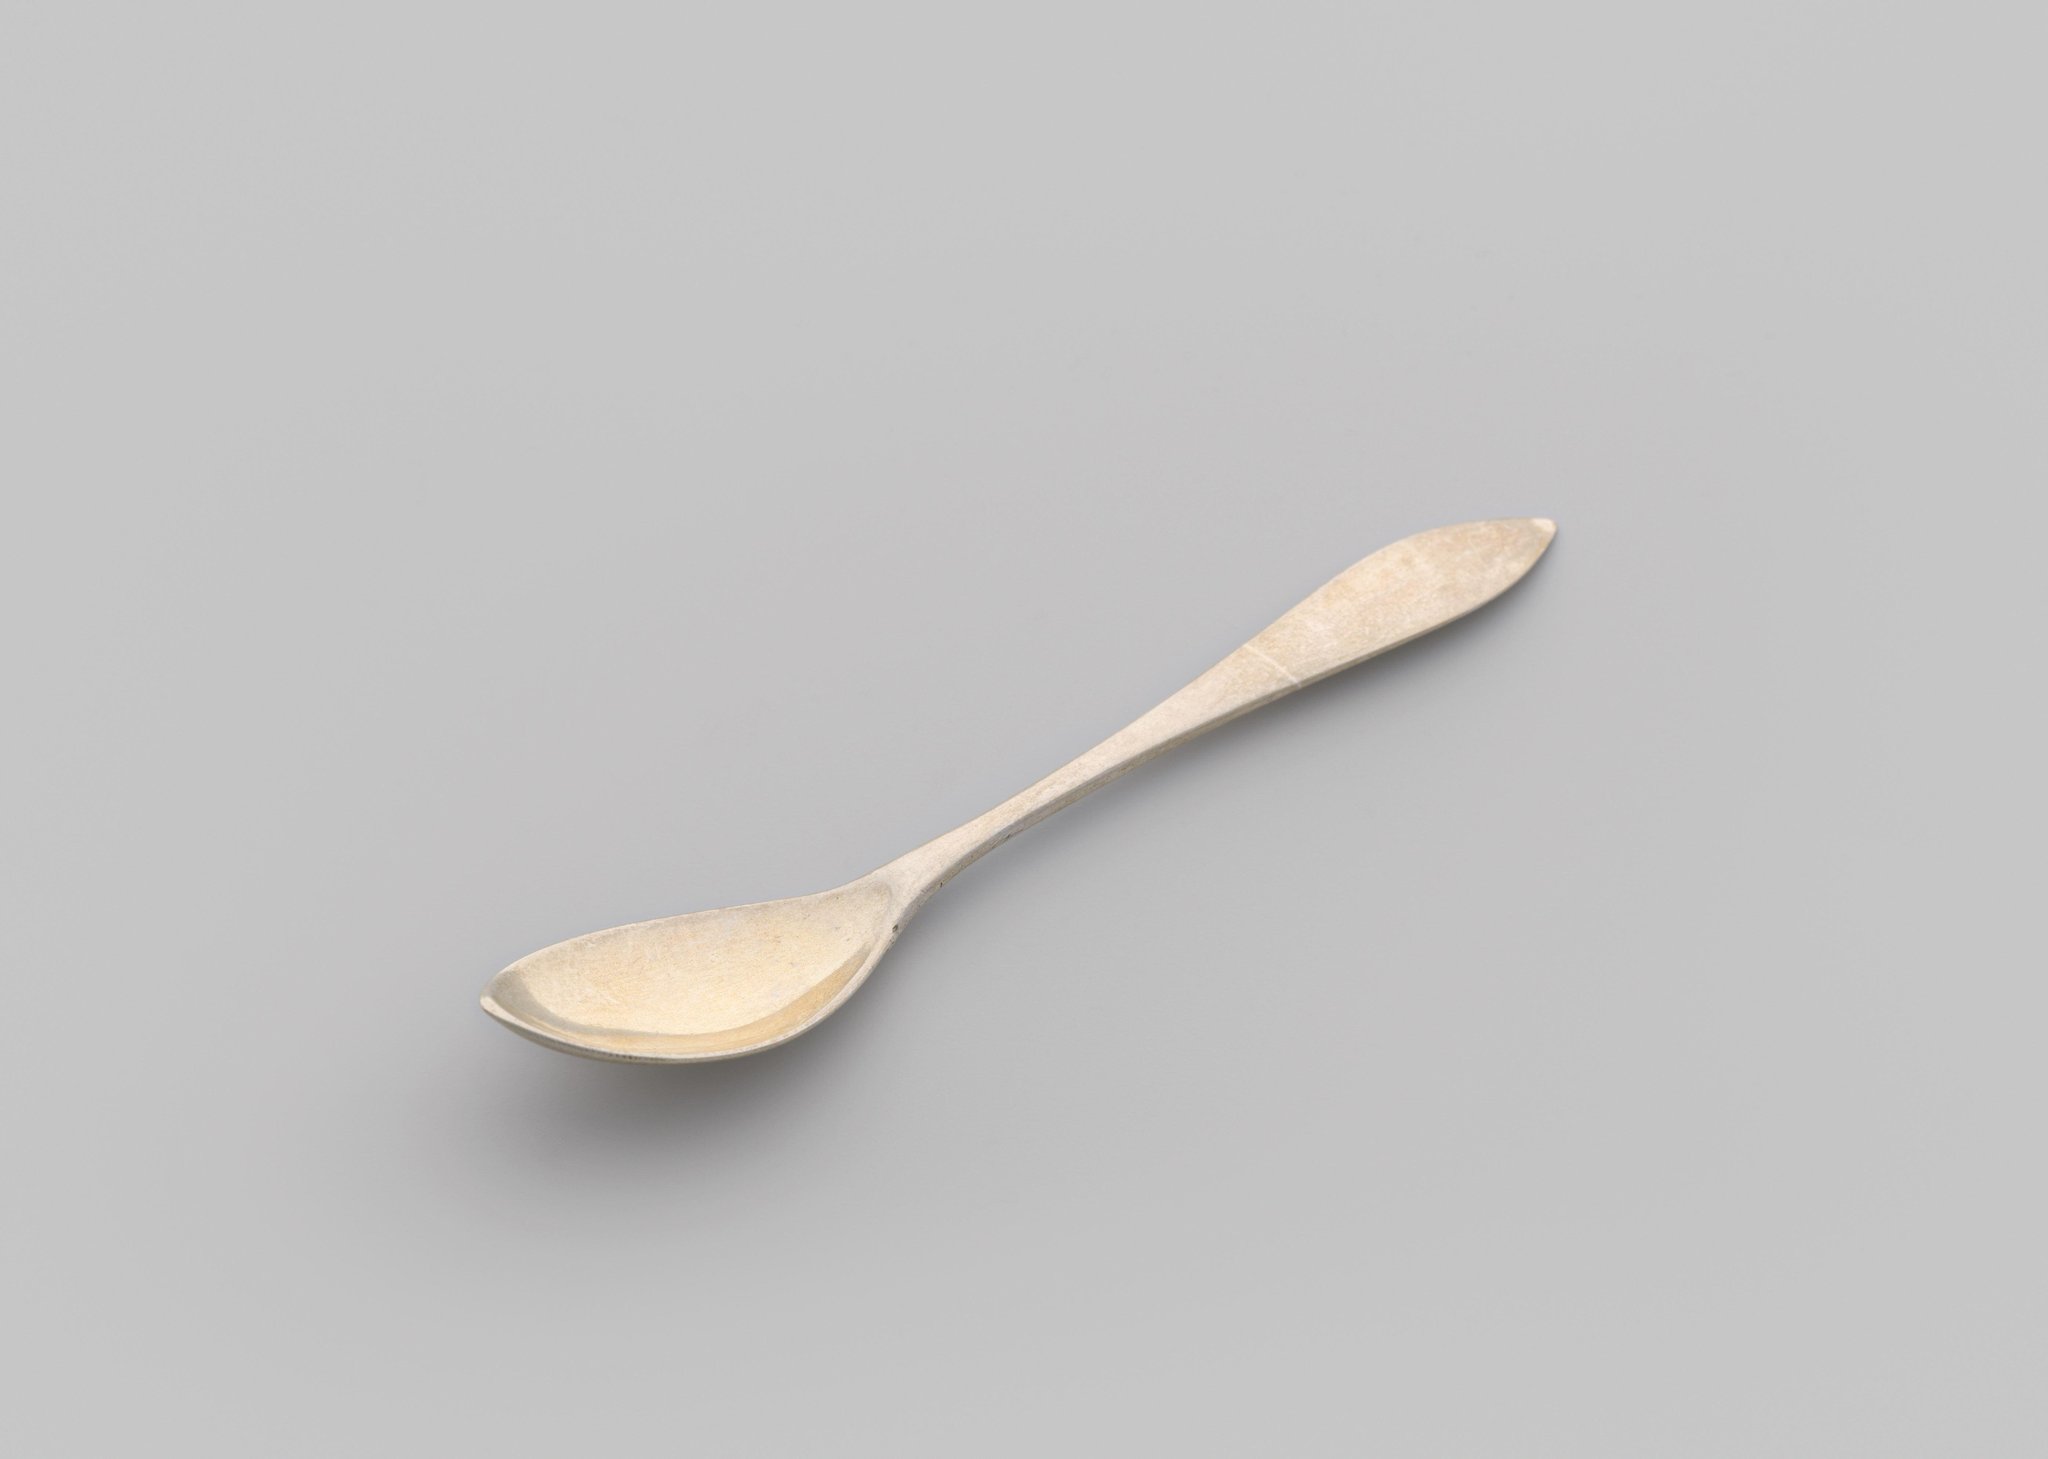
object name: spoon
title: Theelepel met spits ovale bak en platte, gebogen steel, die zich verbreedt naar het spitse uiteinde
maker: hendrik overhulsman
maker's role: silversmith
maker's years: 1756-1836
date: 1804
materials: silver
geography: amsterdam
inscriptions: town mark, date letter: ‘V’, maker's mark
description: De spits ovale bak is door middel van enkel lof verbonden met de platte, gebogen steel, die zich verbreedt naar het spitse uiteinde.